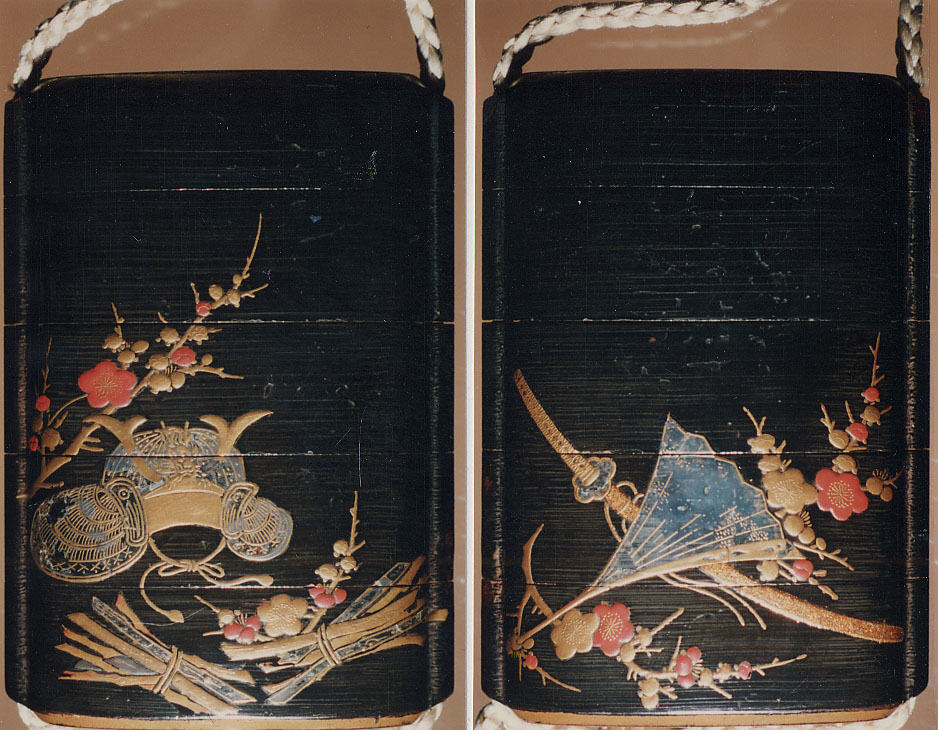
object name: inrō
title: Case (Inrō) with Object from the Noh drama "Hachinoki"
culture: japanese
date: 1801-1900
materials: amber, wood, gold, lacquer, mother of pearl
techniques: carving, inlay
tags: fans,helmets,swords,flowers